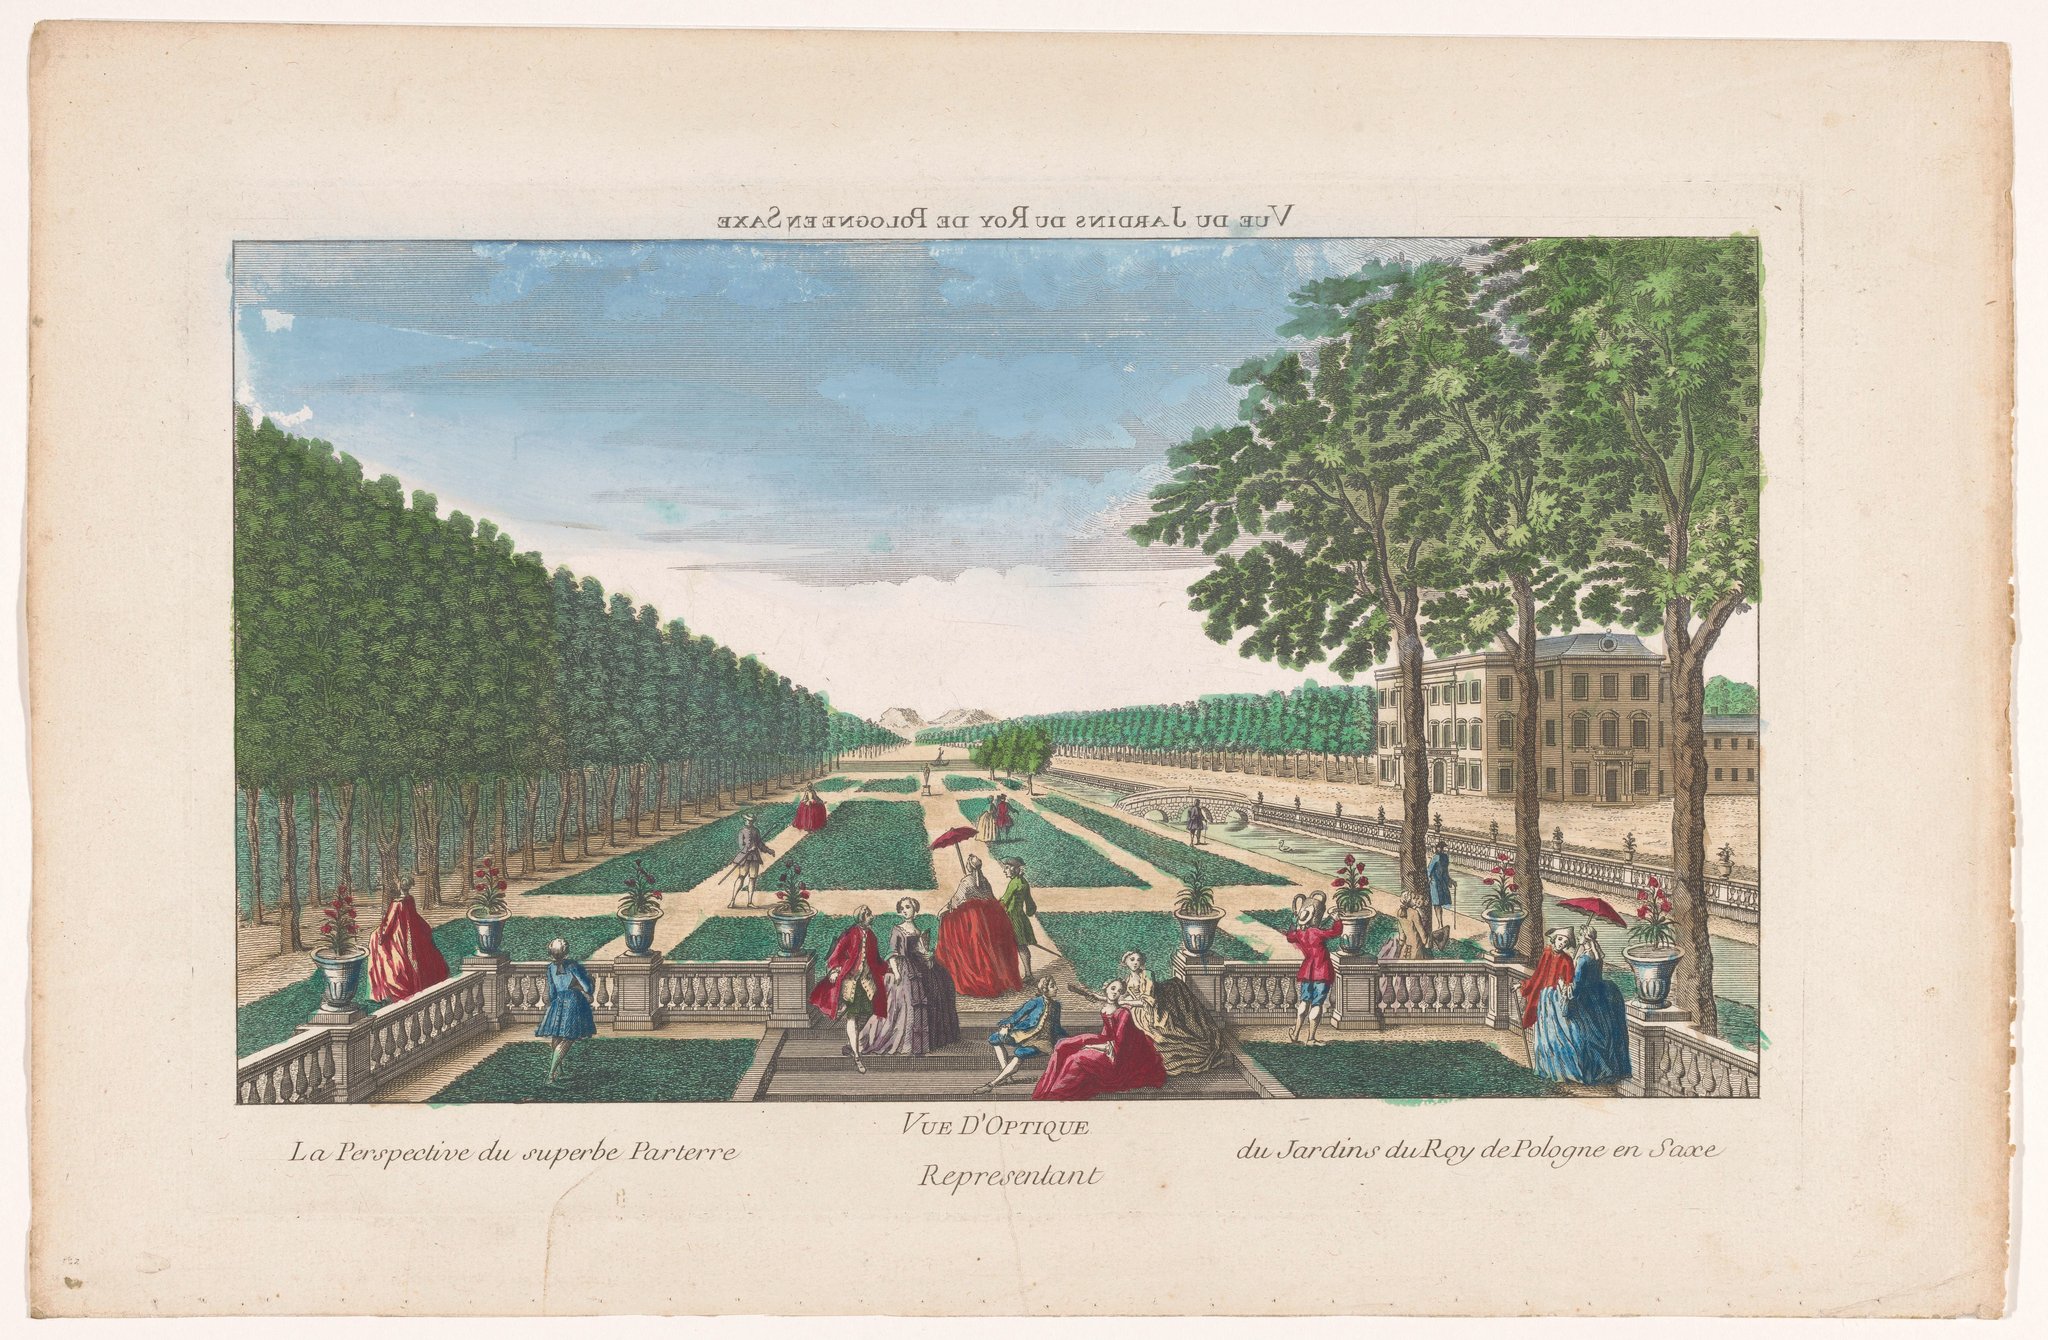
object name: print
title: Vue d'optique representant du jardins du roy de Pologne en Saxe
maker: Anonymous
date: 1700-1799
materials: paper, watercolor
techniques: brush, etching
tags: garden, civic architecture; edifices; dwellings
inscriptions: watermark, collector's mark: Lugt 2166